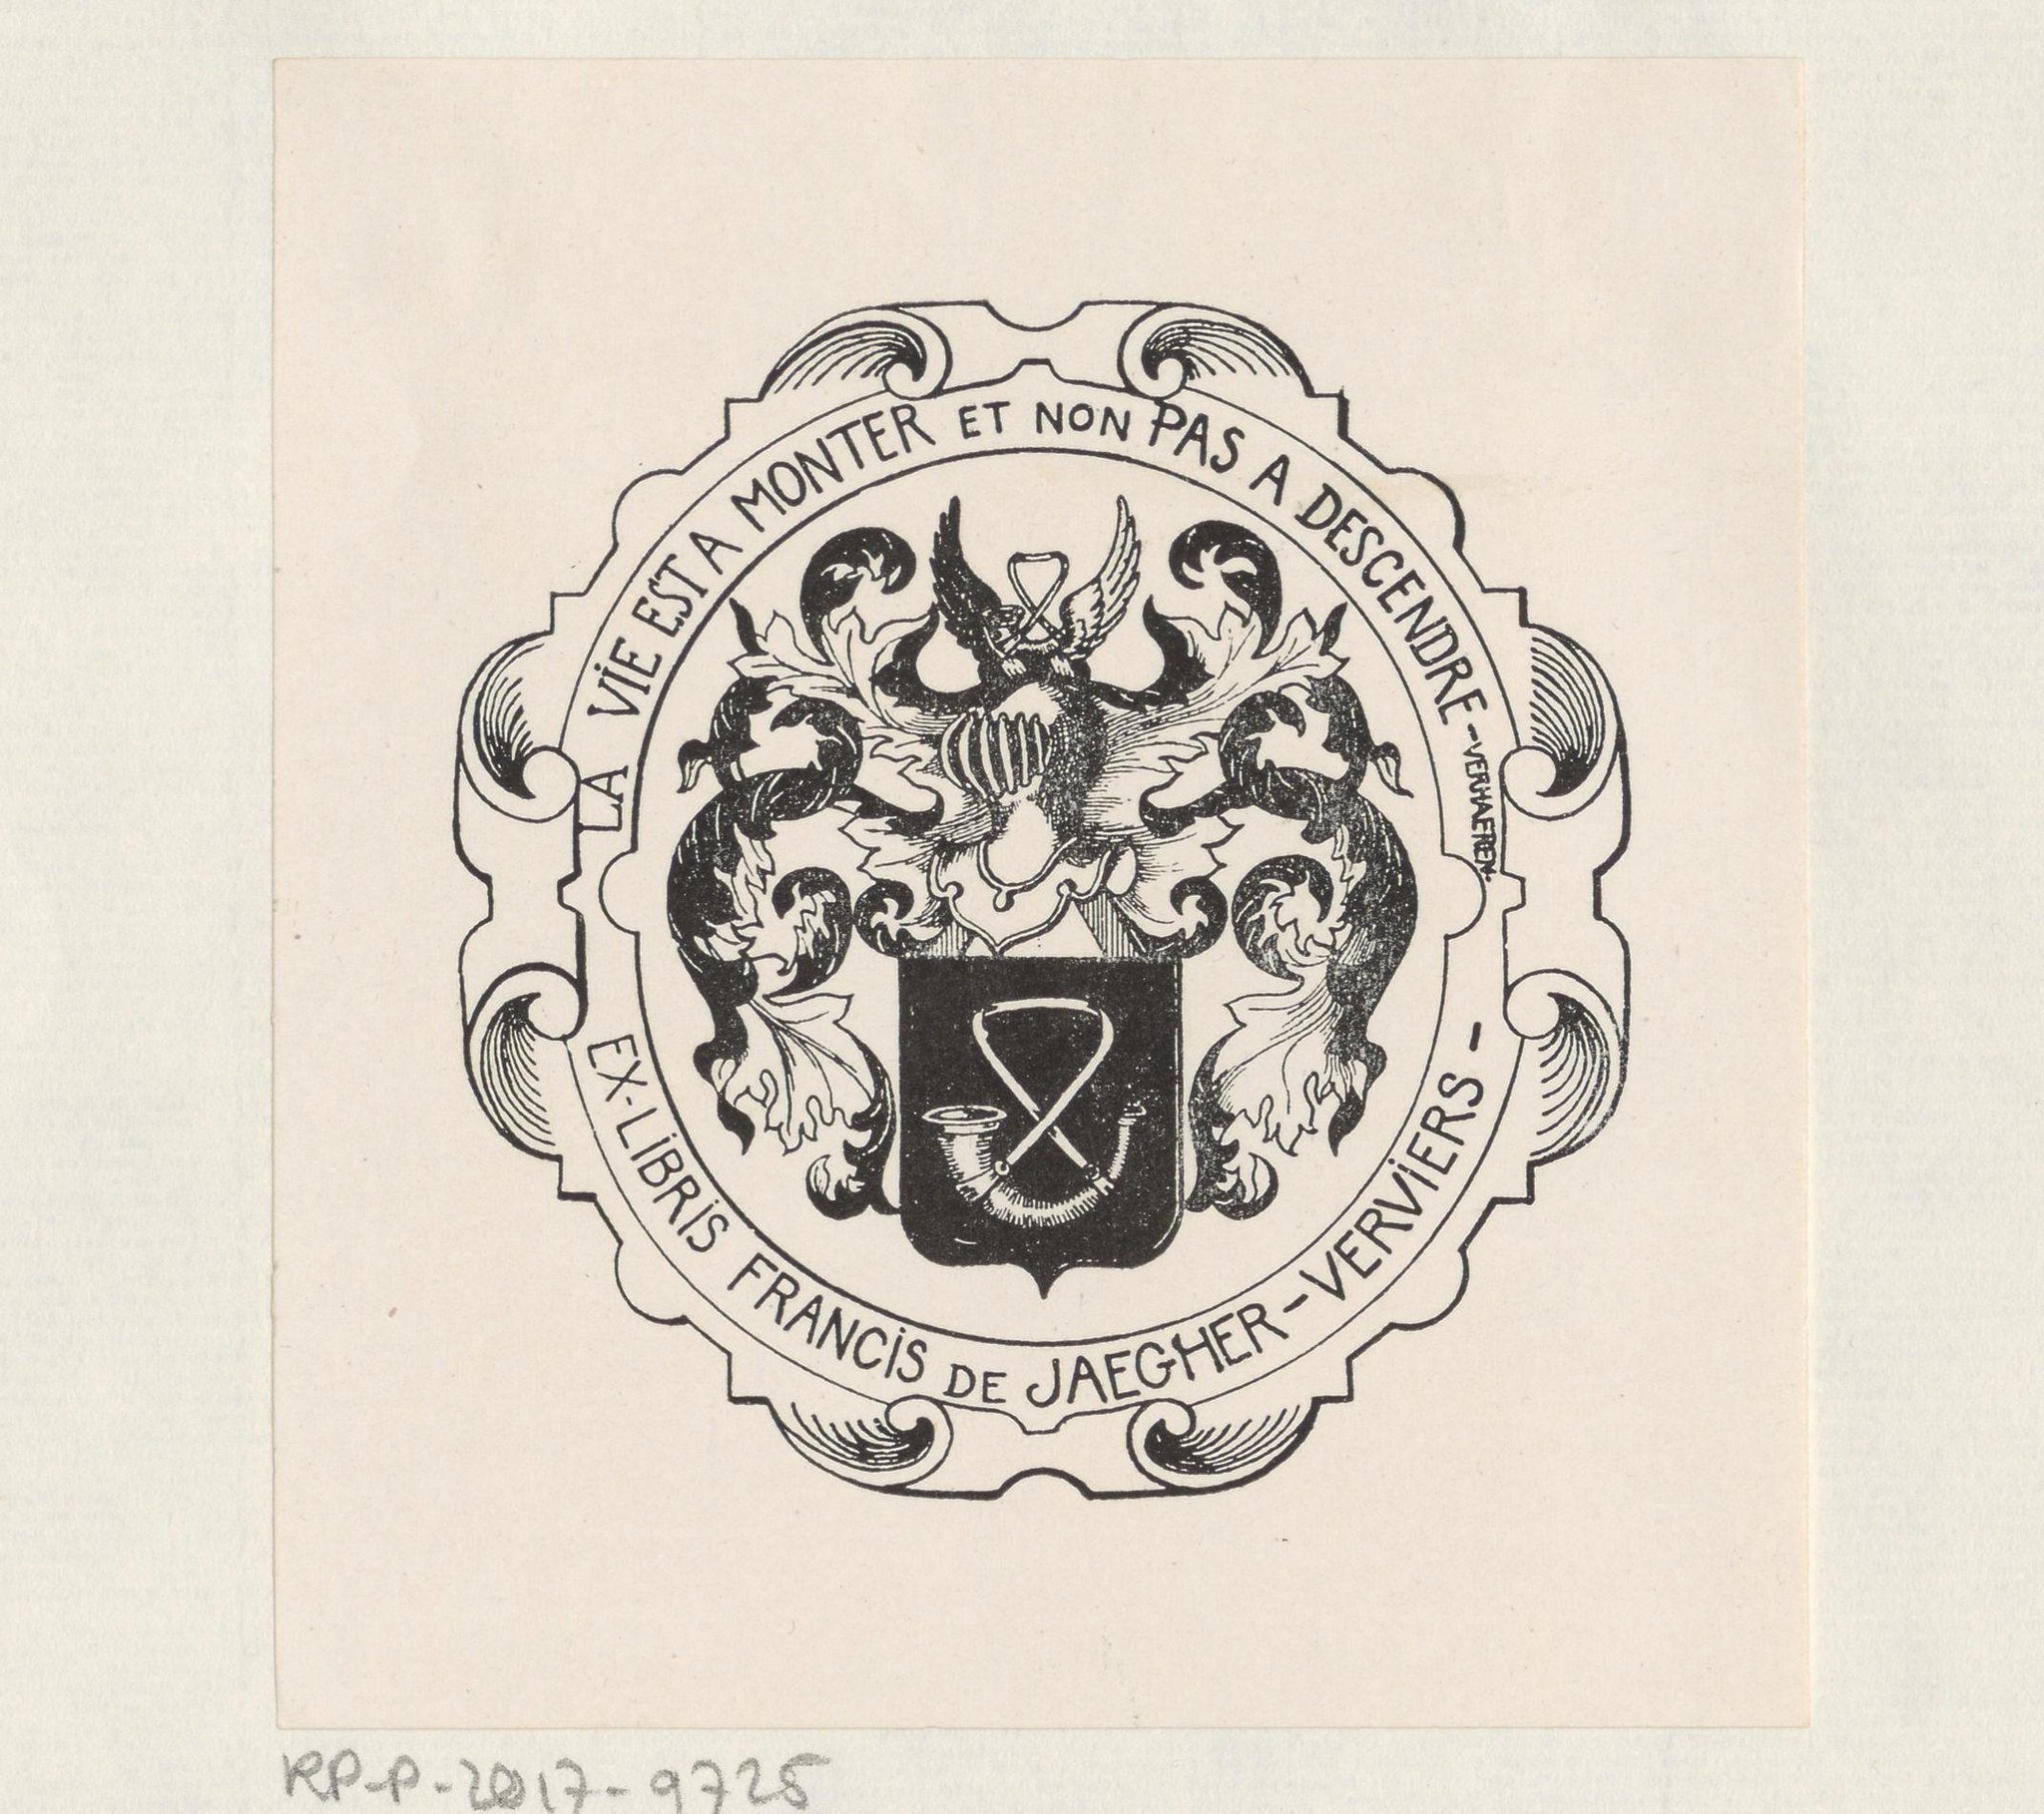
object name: bookplate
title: La vie est a monter et non pas a descendre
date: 1900-1999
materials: paper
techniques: printing block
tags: hunting horn, armorial bearing, heraldry